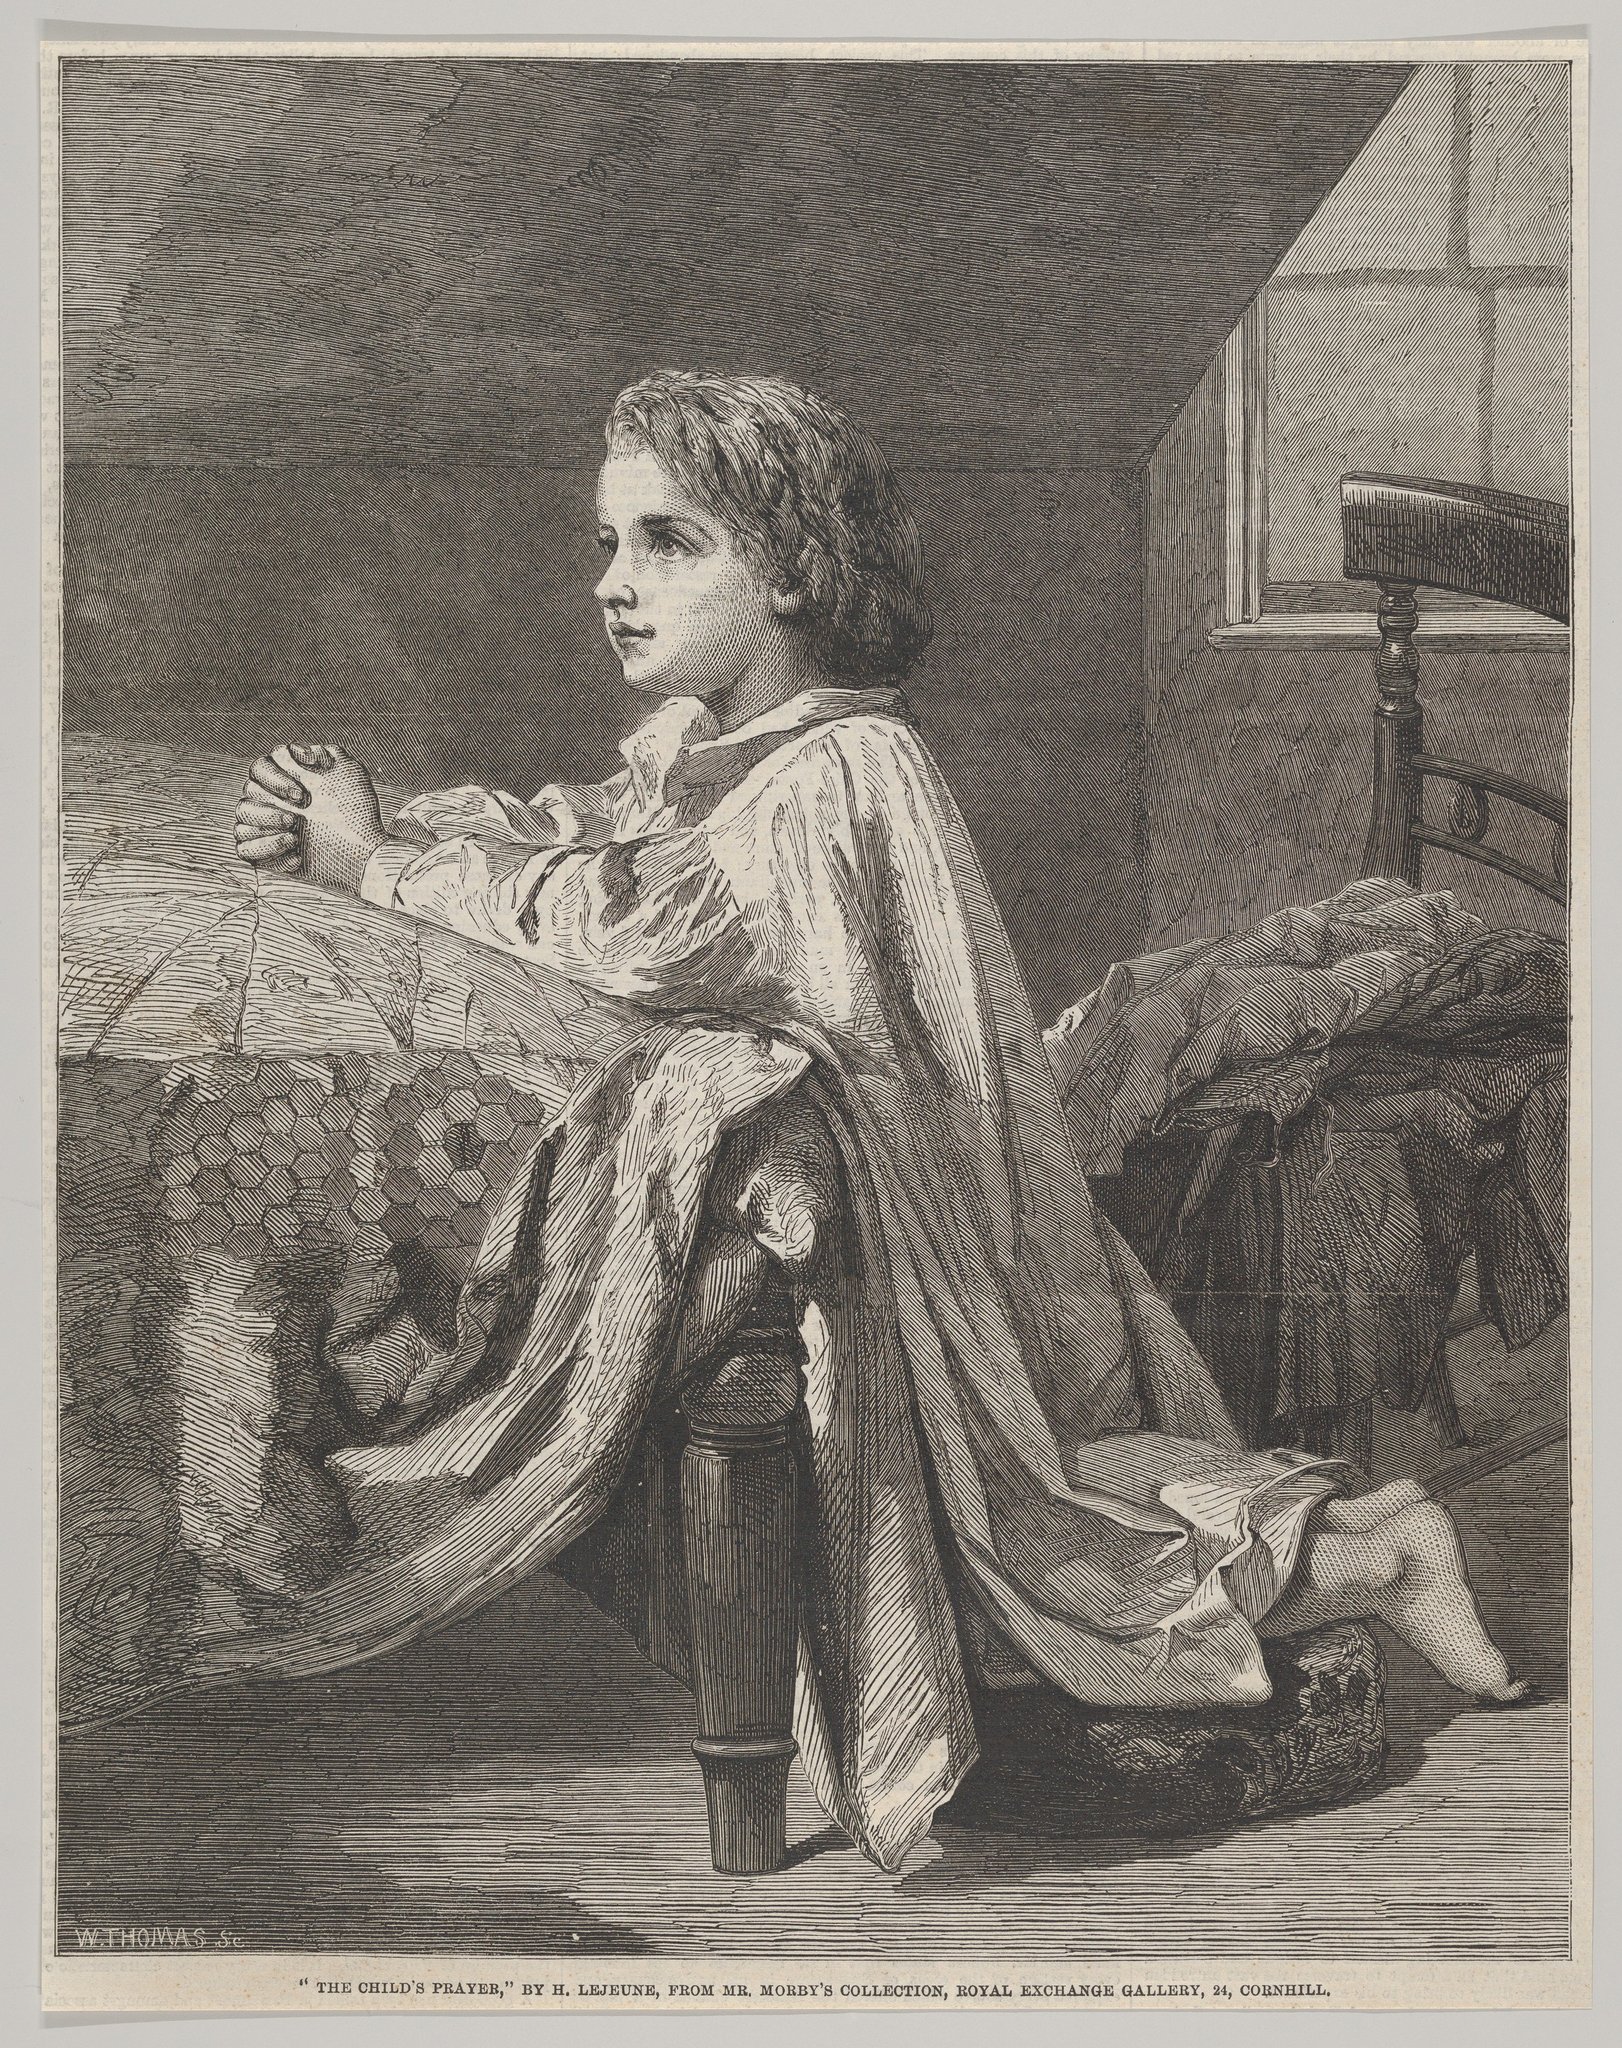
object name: print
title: The Child's Prayer, from "Illustrated London News"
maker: william luson thomas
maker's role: engraver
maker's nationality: british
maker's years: 1830-1900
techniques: engraving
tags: girls,praying